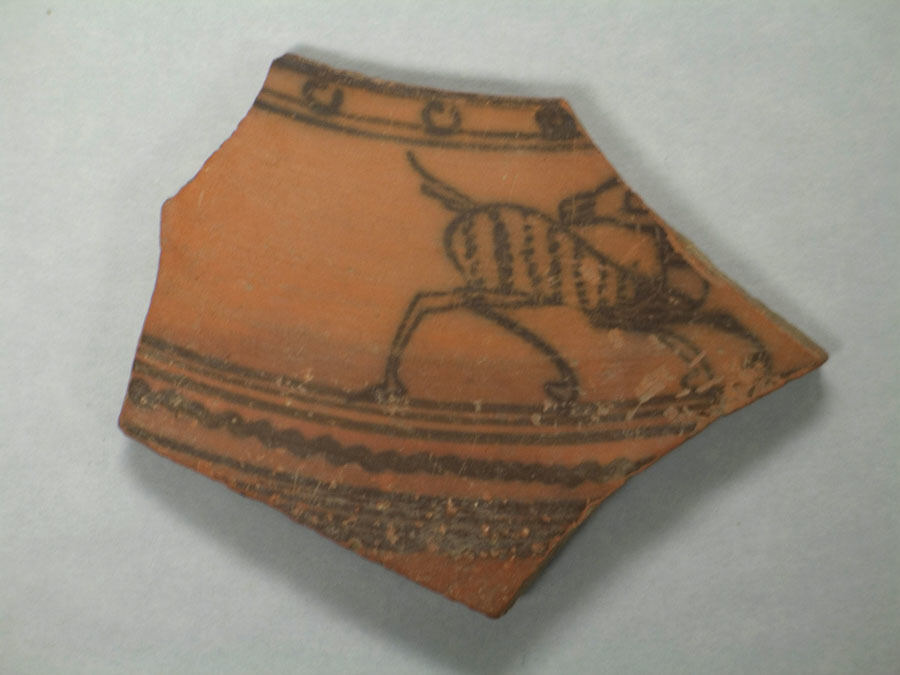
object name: shard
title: Shard with Figural Decoration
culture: pakistani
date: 301-500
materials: terracotta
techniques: painting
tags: animals,gandhara